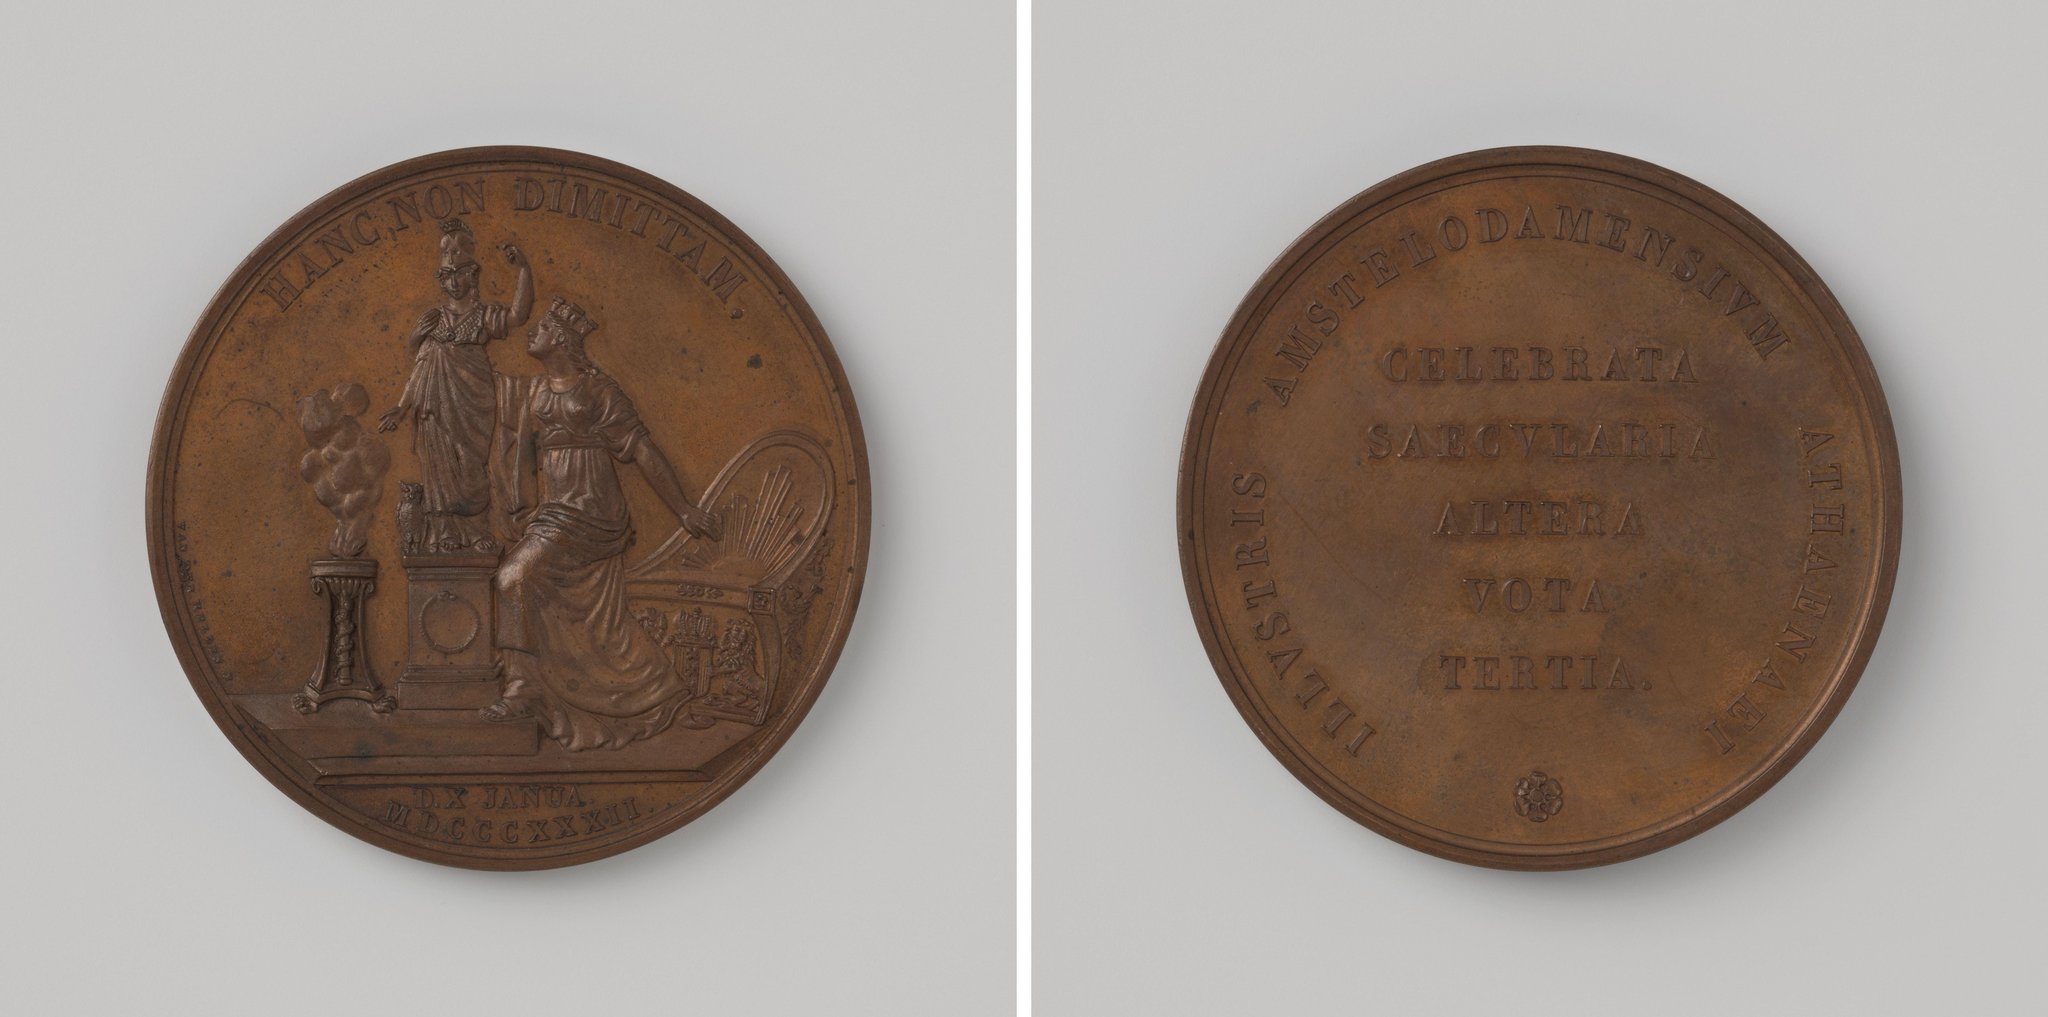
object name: history medal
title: Tweehonderdjarig bestaan van het Athenaeum te Amsterdam 1832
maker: david van der kellen (1804-1879)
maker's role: die cutter, draughtsman, print maker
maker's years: 1804-1879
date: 1832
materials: bronze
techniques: striking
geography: utrecht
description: Bronzen penning, op de voorzijde de Amsterdamse stadsgodin, opgestaan uit haar zetel, omhelst een standbeeld van Minerva, staand op een zuil waarop een slangenrond afgebeeld, waarnaast een brandende driepoot, met omschrift en afsnedetekst, op de keerzijde vijf regels tekst met omschrift.